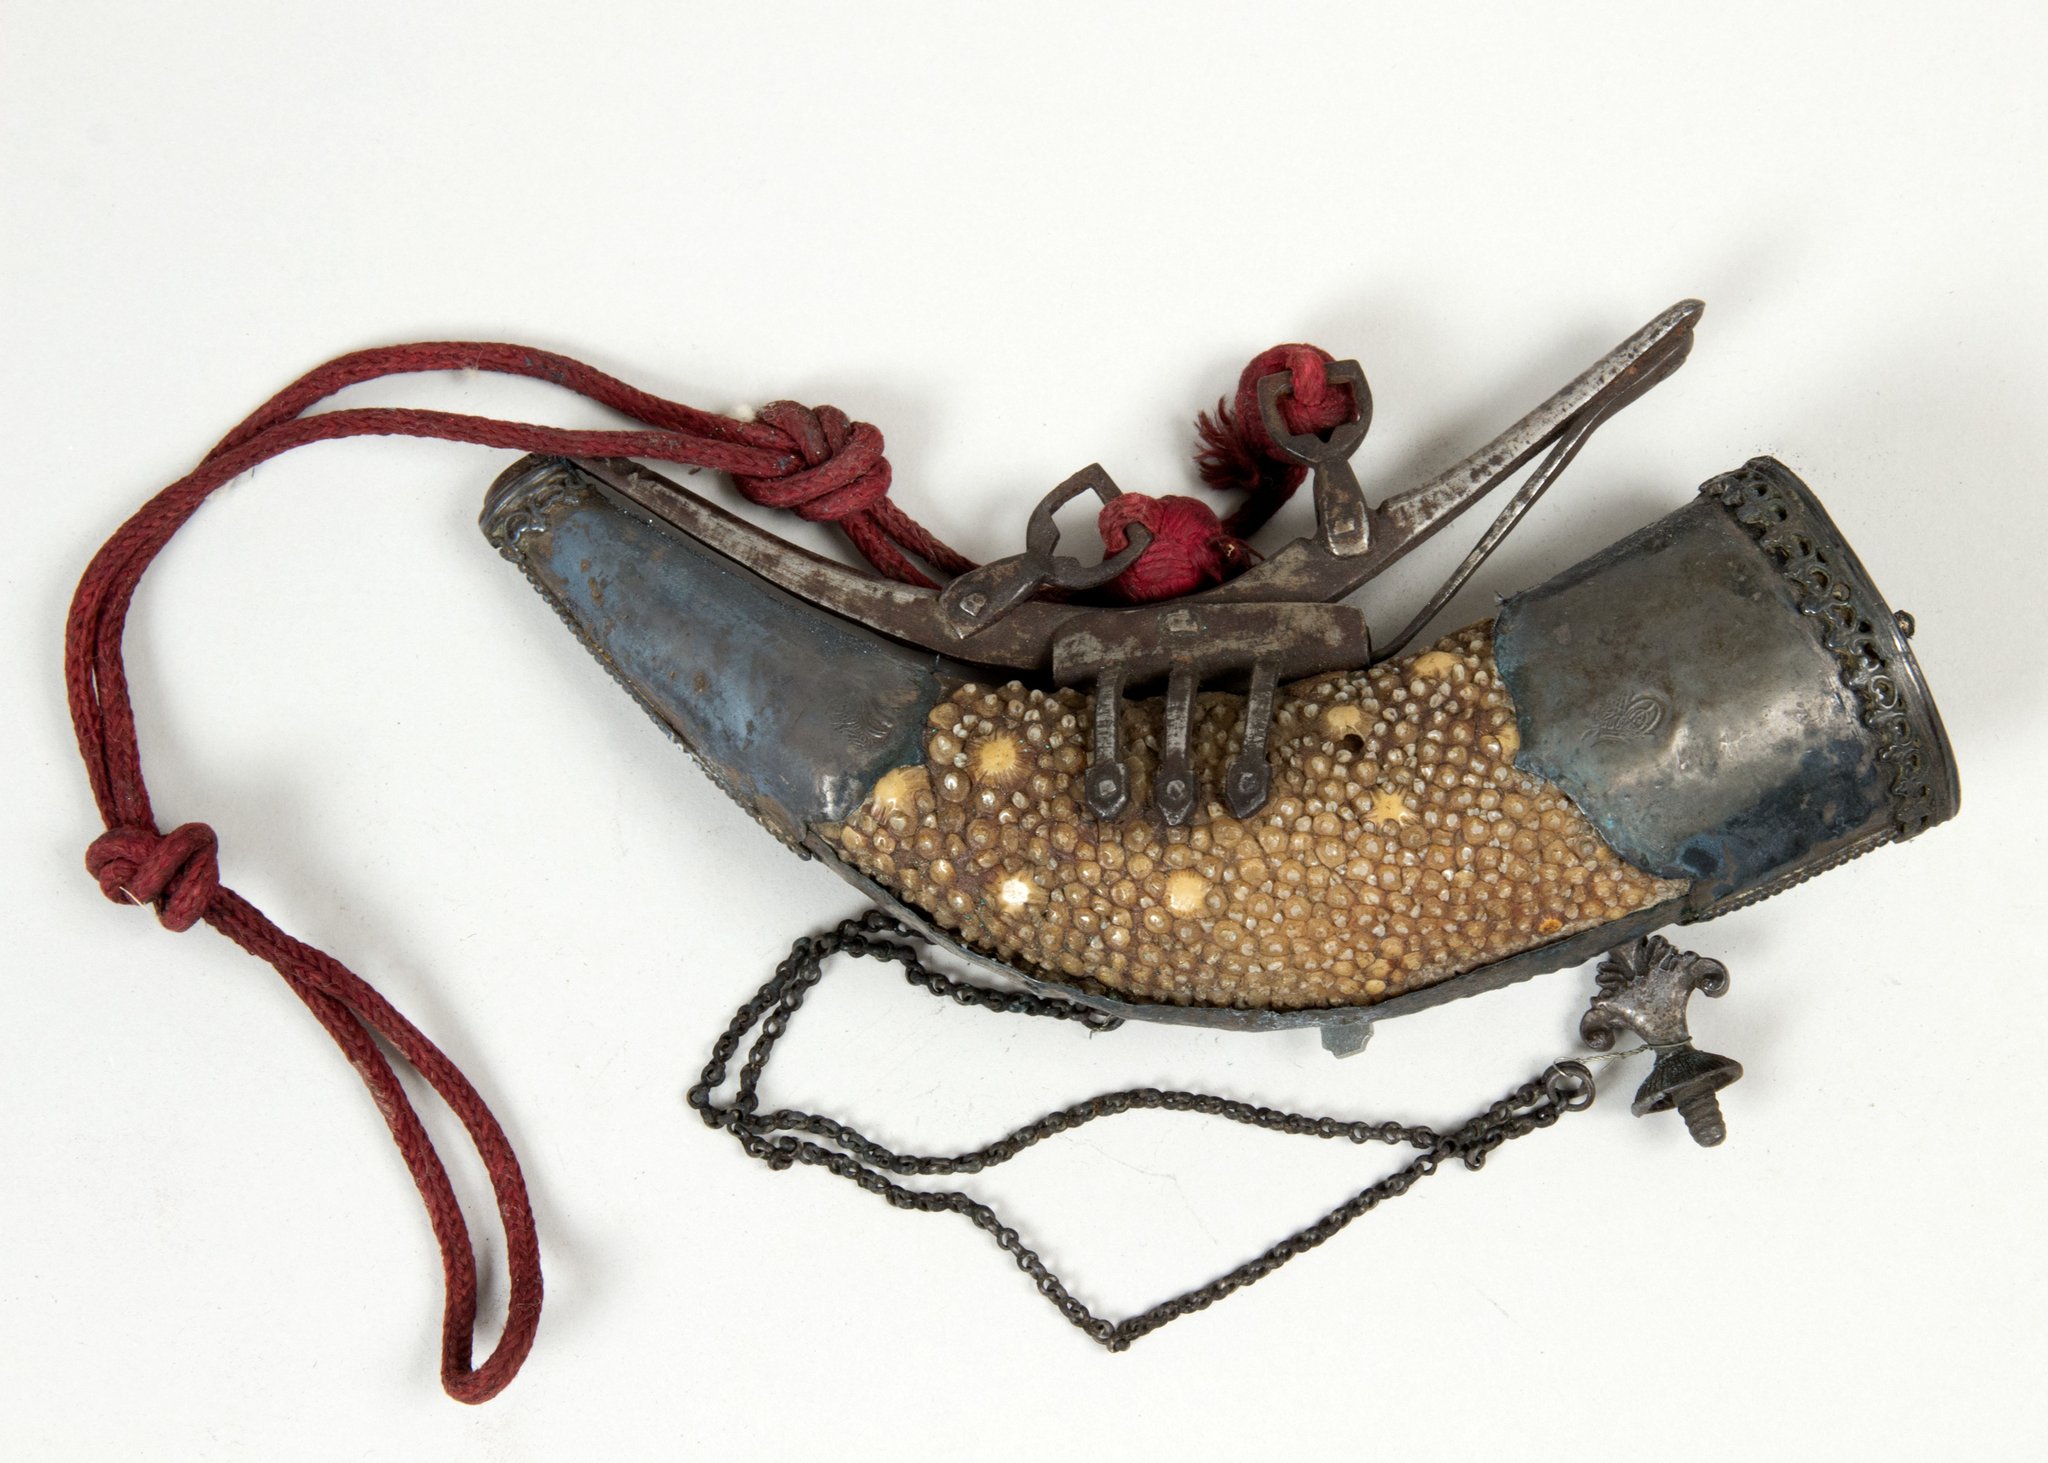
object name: primer with cord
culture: turkish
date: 1701-1800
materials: silver, skin, textile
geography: ottoman empire